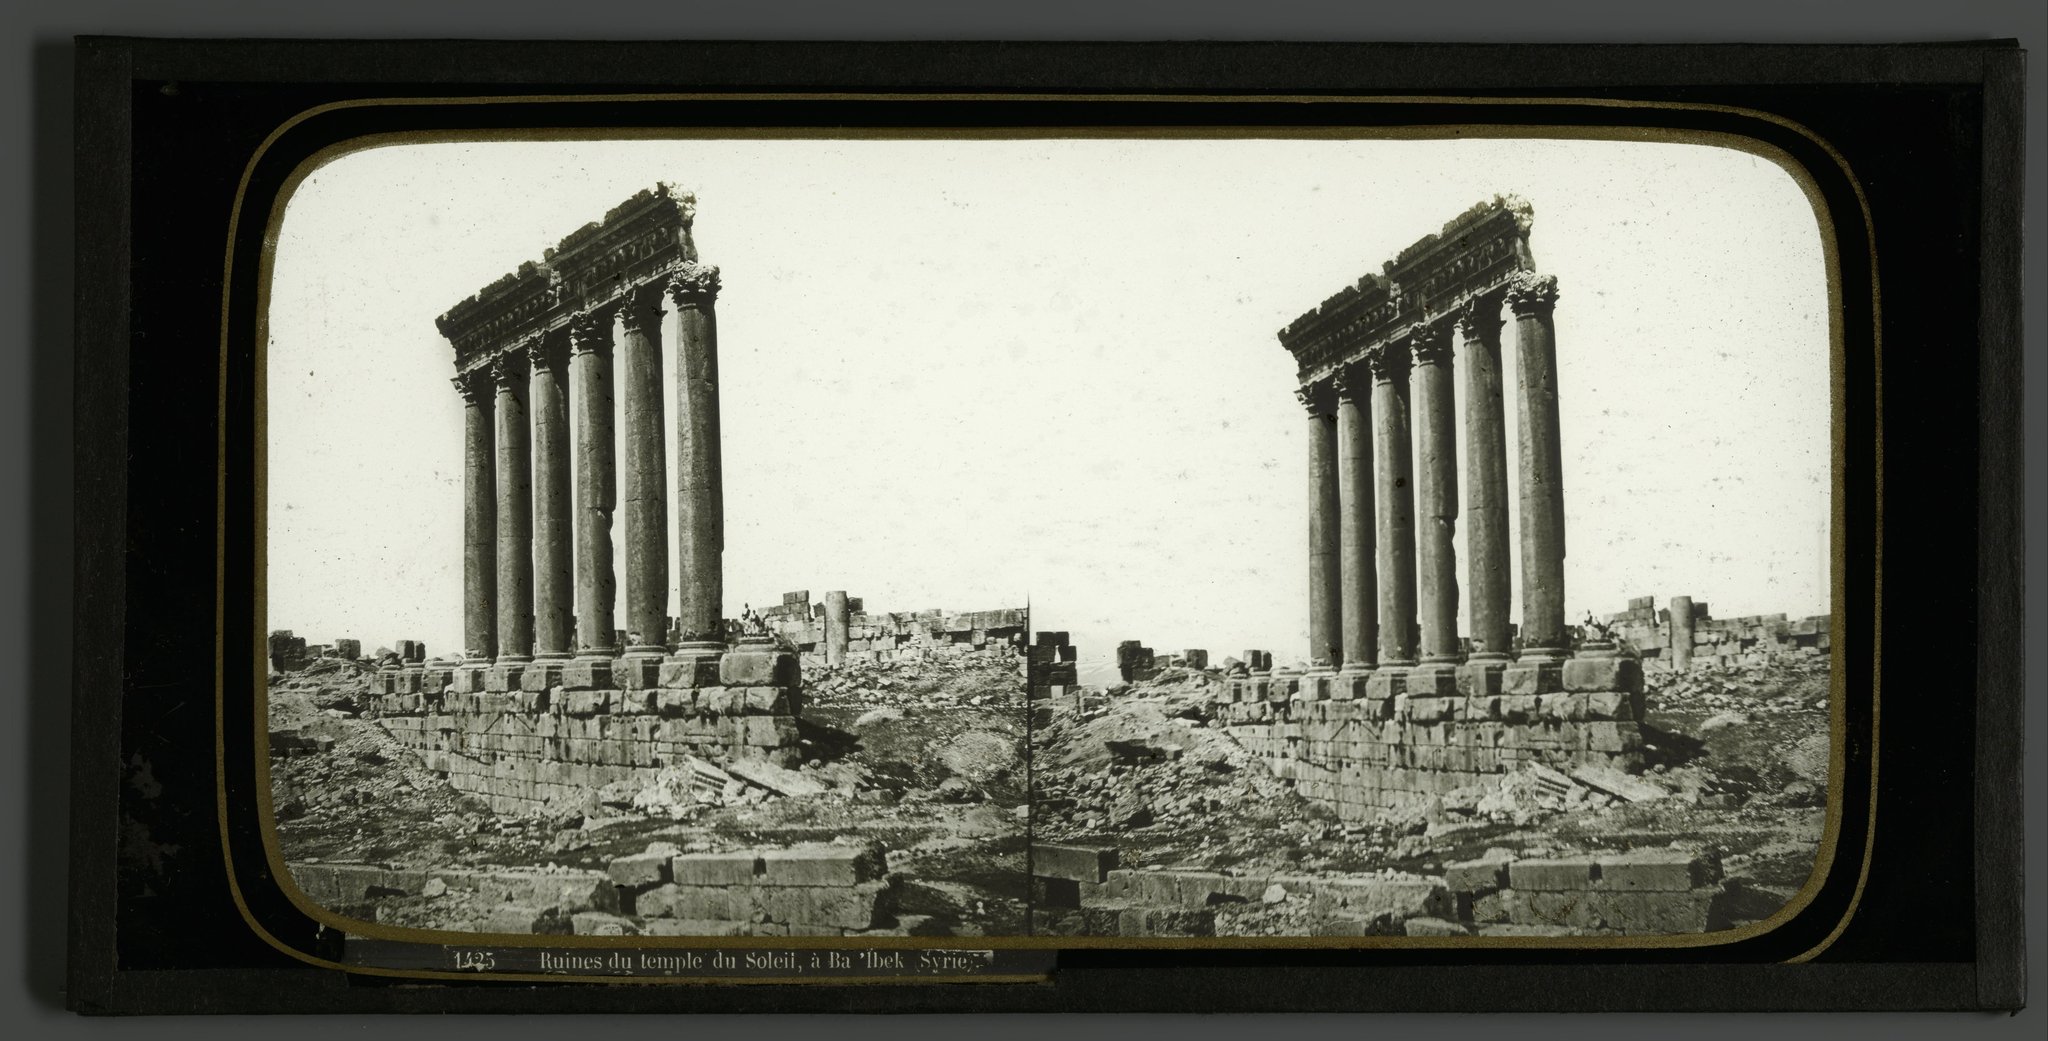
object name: stereoscopic photograph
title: Pilaren van de tempel van Jupiter in Baalbek, Libanon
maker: Anonymous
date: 1860-1890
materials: glass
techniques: slide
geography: baalbek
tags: column, pillar ~ architecture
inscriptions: number: ‘1425’